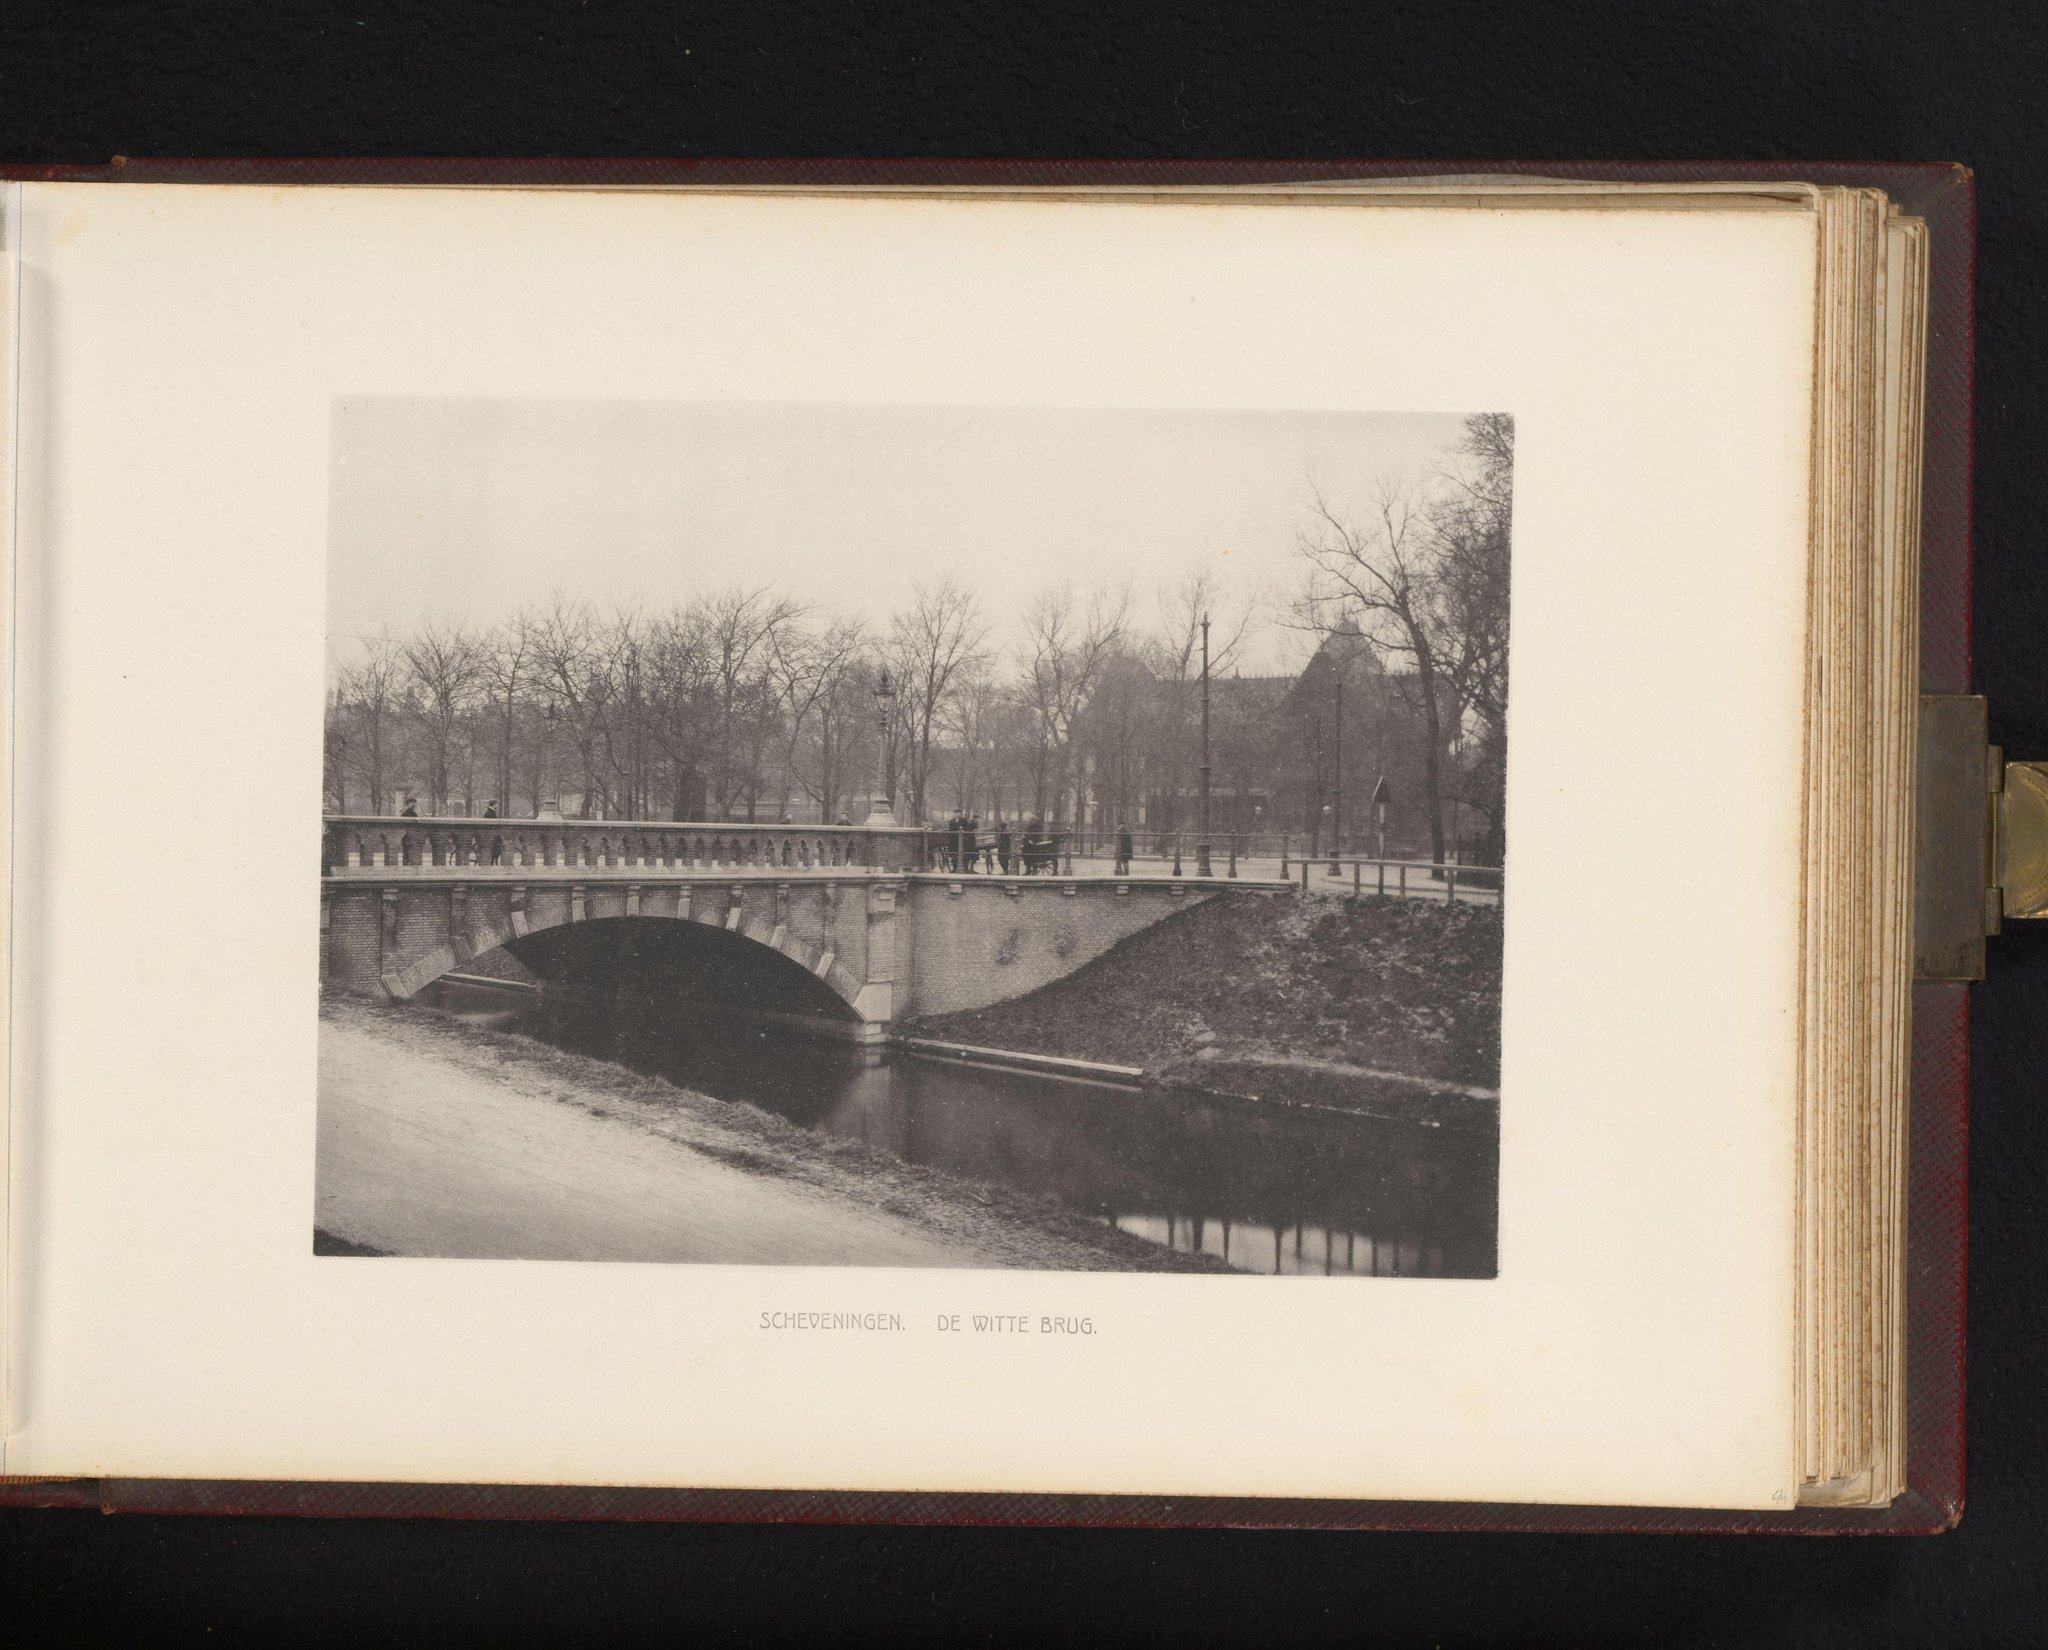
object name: album leaf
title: Gezicht op de Witte Brug te Scheveningen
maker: Anonymous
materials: paper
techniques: photograph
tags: bridge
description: Deze pagina maakt deel uit van een album.